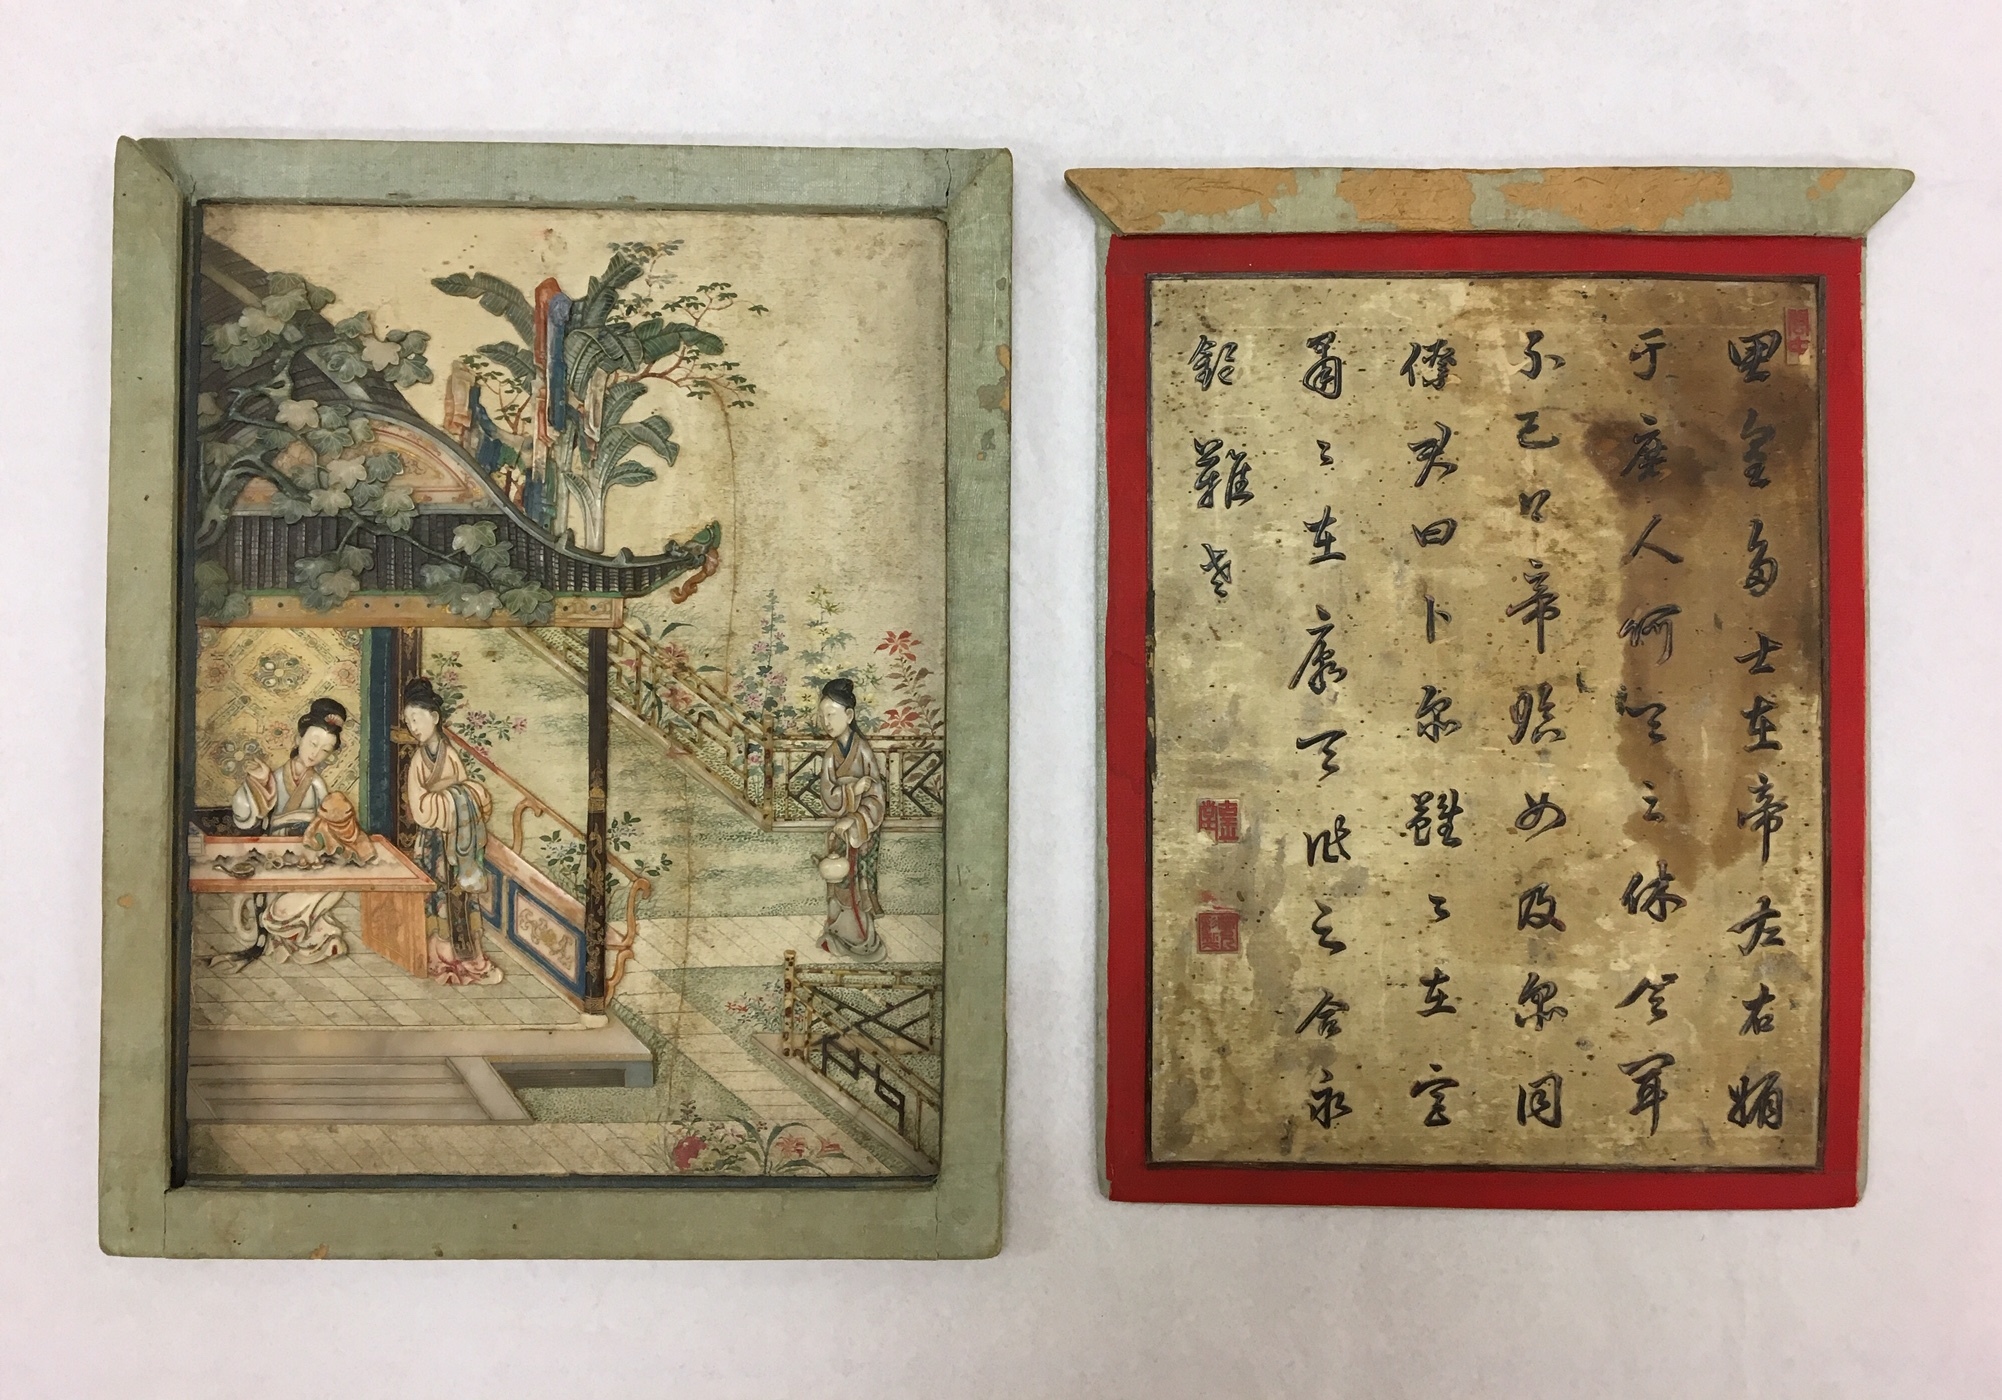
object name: panel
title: Panel Illustrating Feminine Virtue: The Art of Sewing and Embroidery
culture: chinese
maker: lin yuncai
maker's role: artist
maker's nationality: chinese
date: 1601-1700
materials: paper, textile